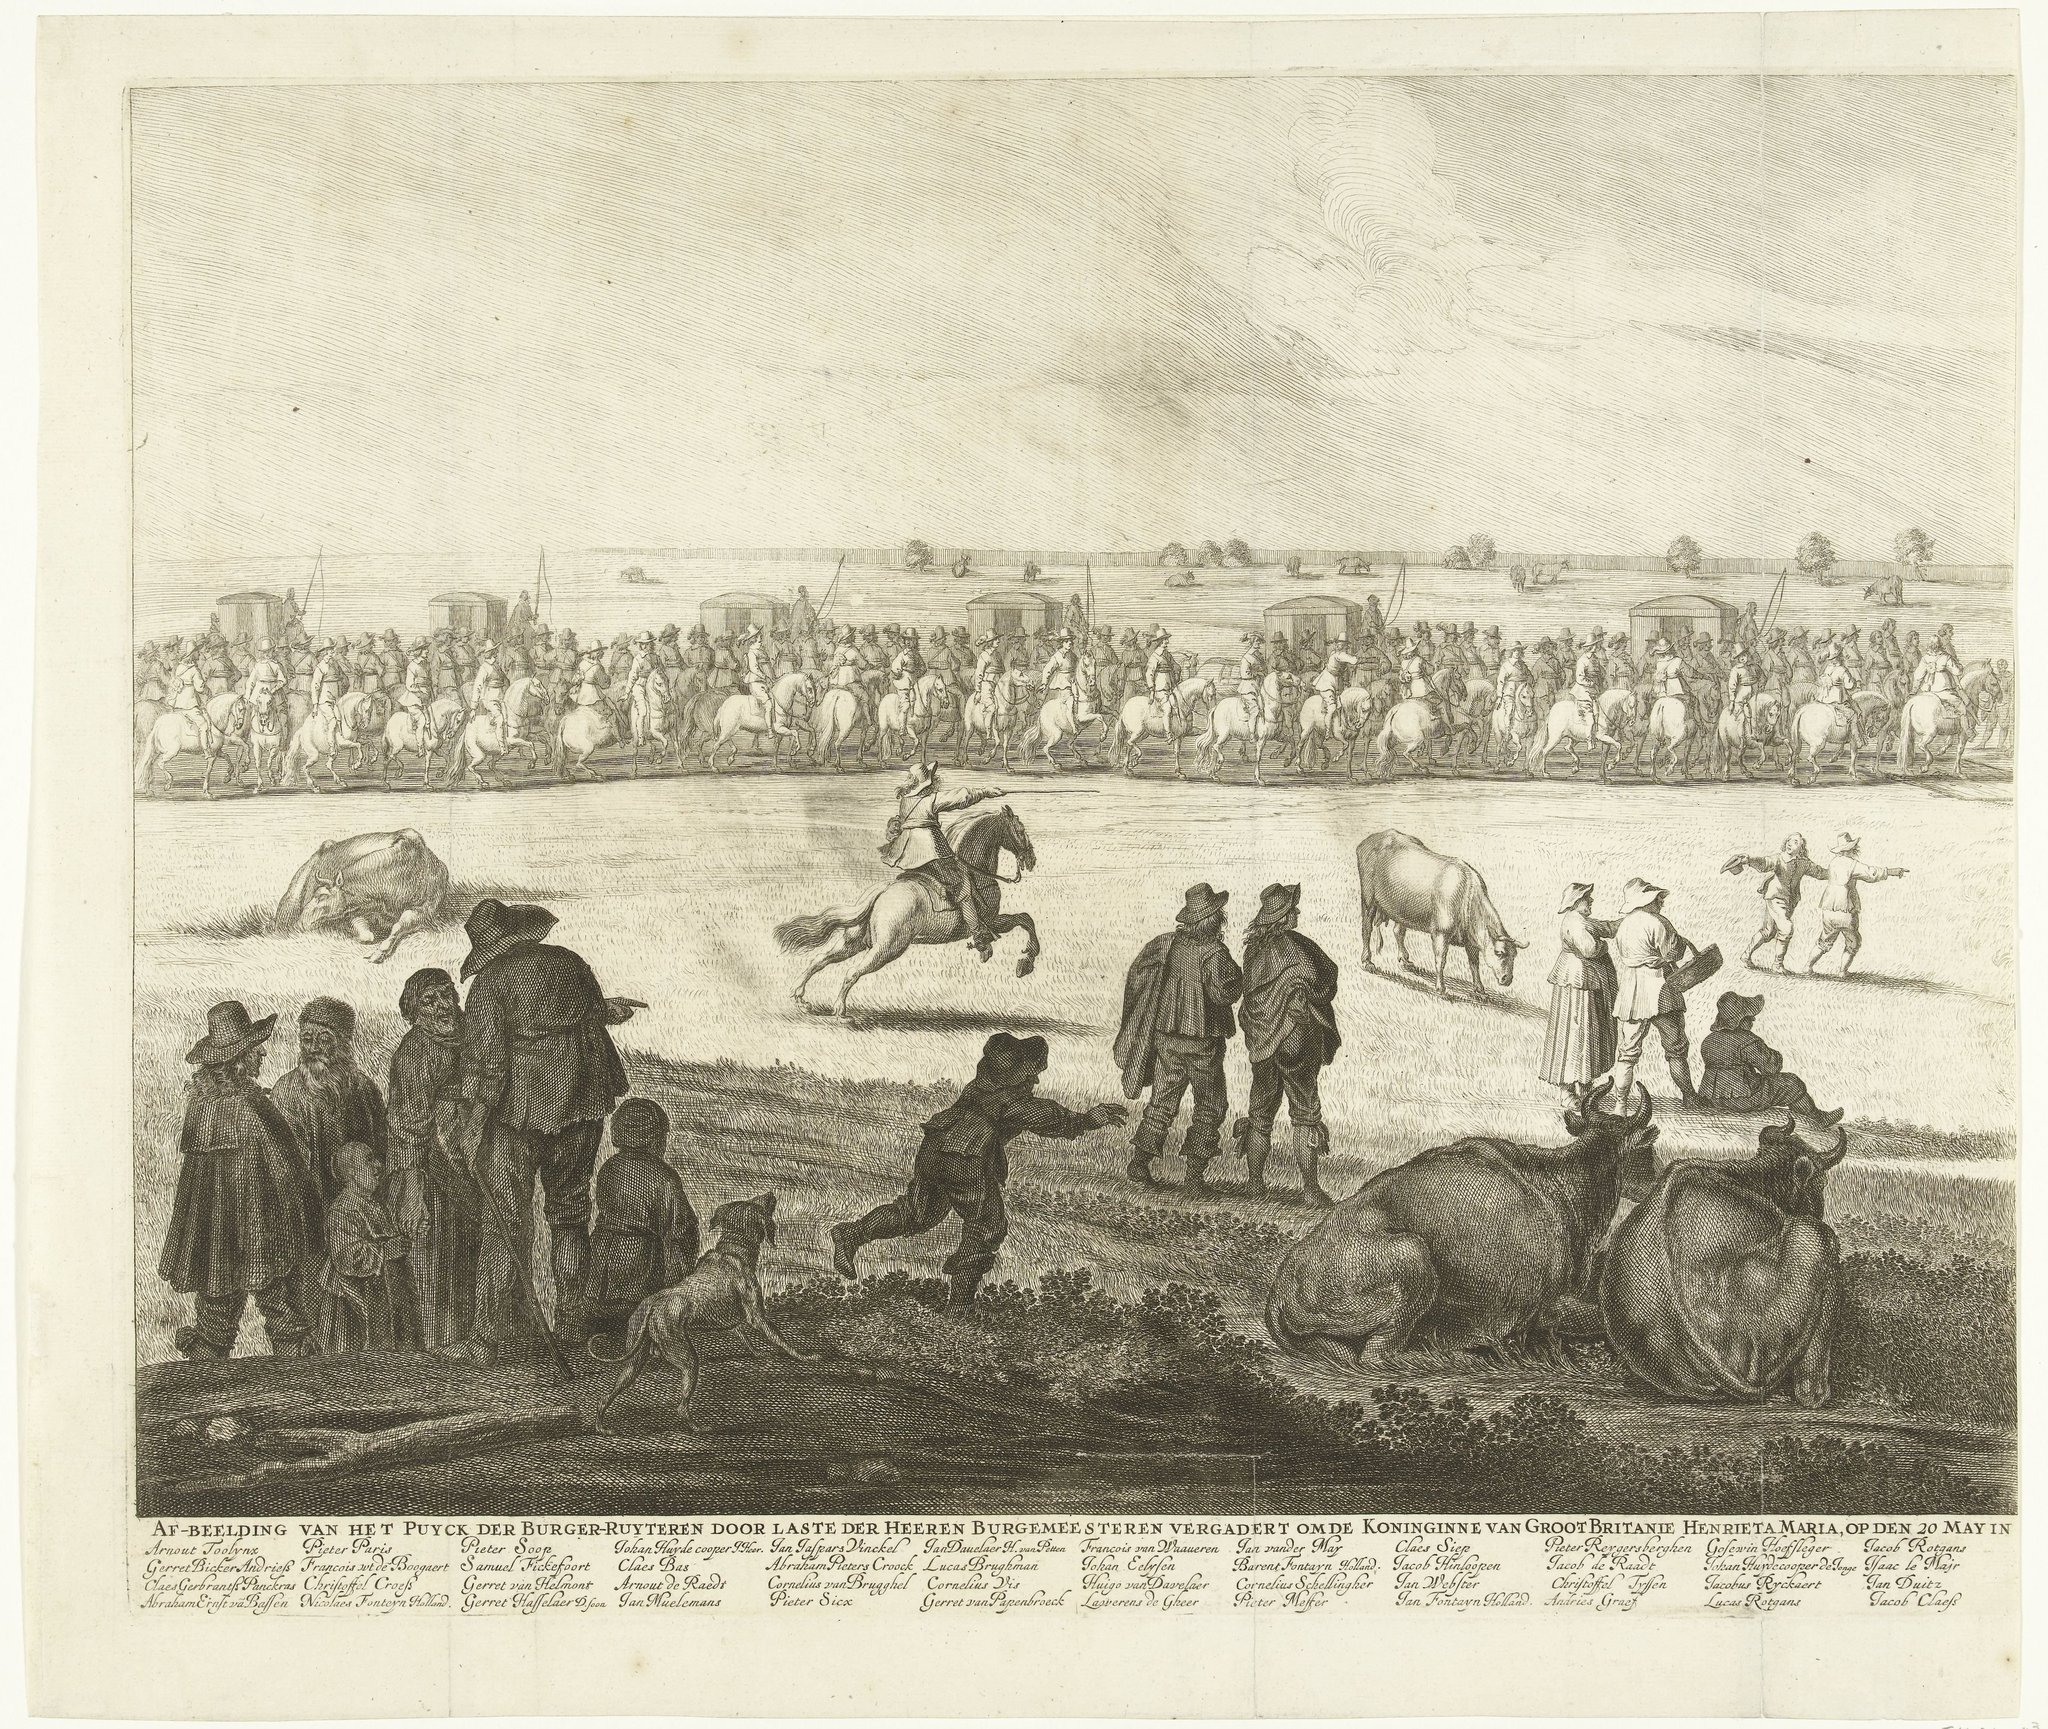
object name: print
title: Optocht van de schutters langs de Haarlemmertrekvaart bij de intocht van koningin Henrietta Maria te Amsterdam, 1642 (linkerblad)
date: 1642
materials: paper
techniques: etching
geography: northern netherlands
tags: henriëtta maria van frankrijk (koningin van engeland, schotland en ierland), triumphal entry and public reception, pageant, 'entrée solennelle', 'joyeuse entrée'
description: Optocht van de schutters langs de Haarlemmertrekvaart bij de intocht van Engelse koningin Henrietta Maria te Amsterdam, 20 mei 1642. Geheel bestaande uit drie bladen: linkerblad. De stoet van zes rijtuigen begeleid door ruiters. Op de voorgrond toeschouwers en vee. In het onderschrift het begin van de titel en een lijst in 12 kolommen met een deel van de namen van de ruiters in de stoet.